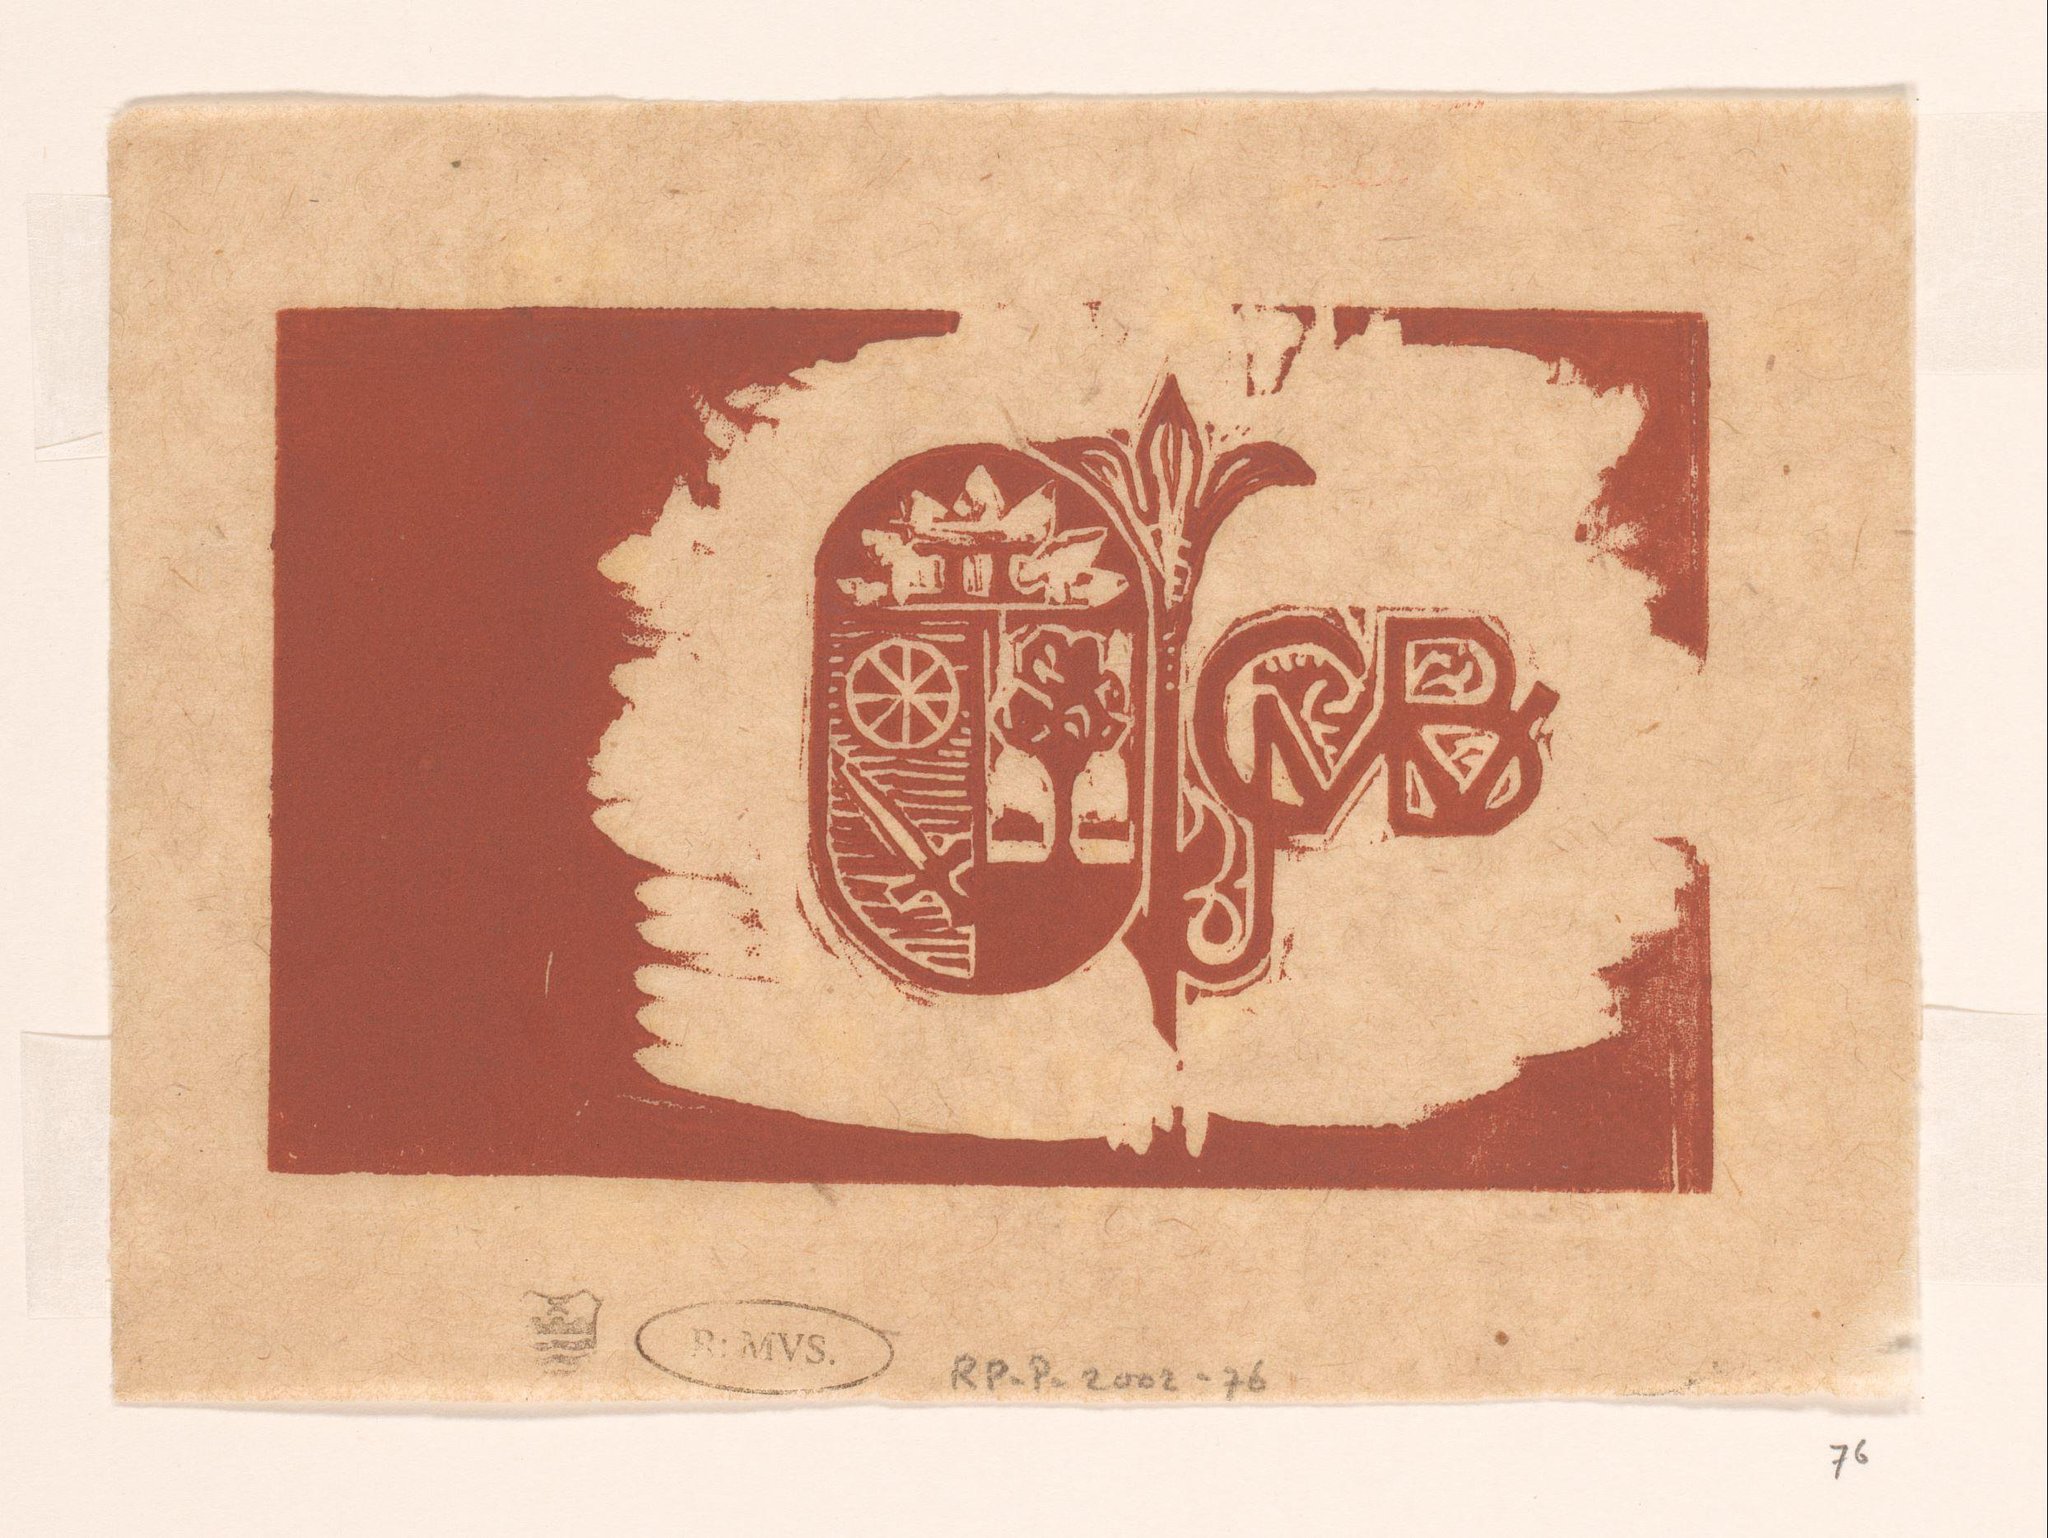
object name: print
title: Vignet met wapenschild en monogram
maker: bernard willem wierink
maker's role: draughtsman, print maker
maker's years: 1856-1939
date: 1871-1939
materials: paper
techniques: relief print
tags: vignette, armorial bearing, heraldry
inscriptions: collector's mark: Lugt 2760, collector's mark: Lugt 2228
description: Deze prent is vermoedelijk een plaatsnede, ook al wordt in de literatuur veelal gesproken over een houtsnede. Voor zover Wierink zijn prenten in hoogdruk zelf nader heeft omschreven, heeft hij altijd de term 'plaatsnede' gebruikt.